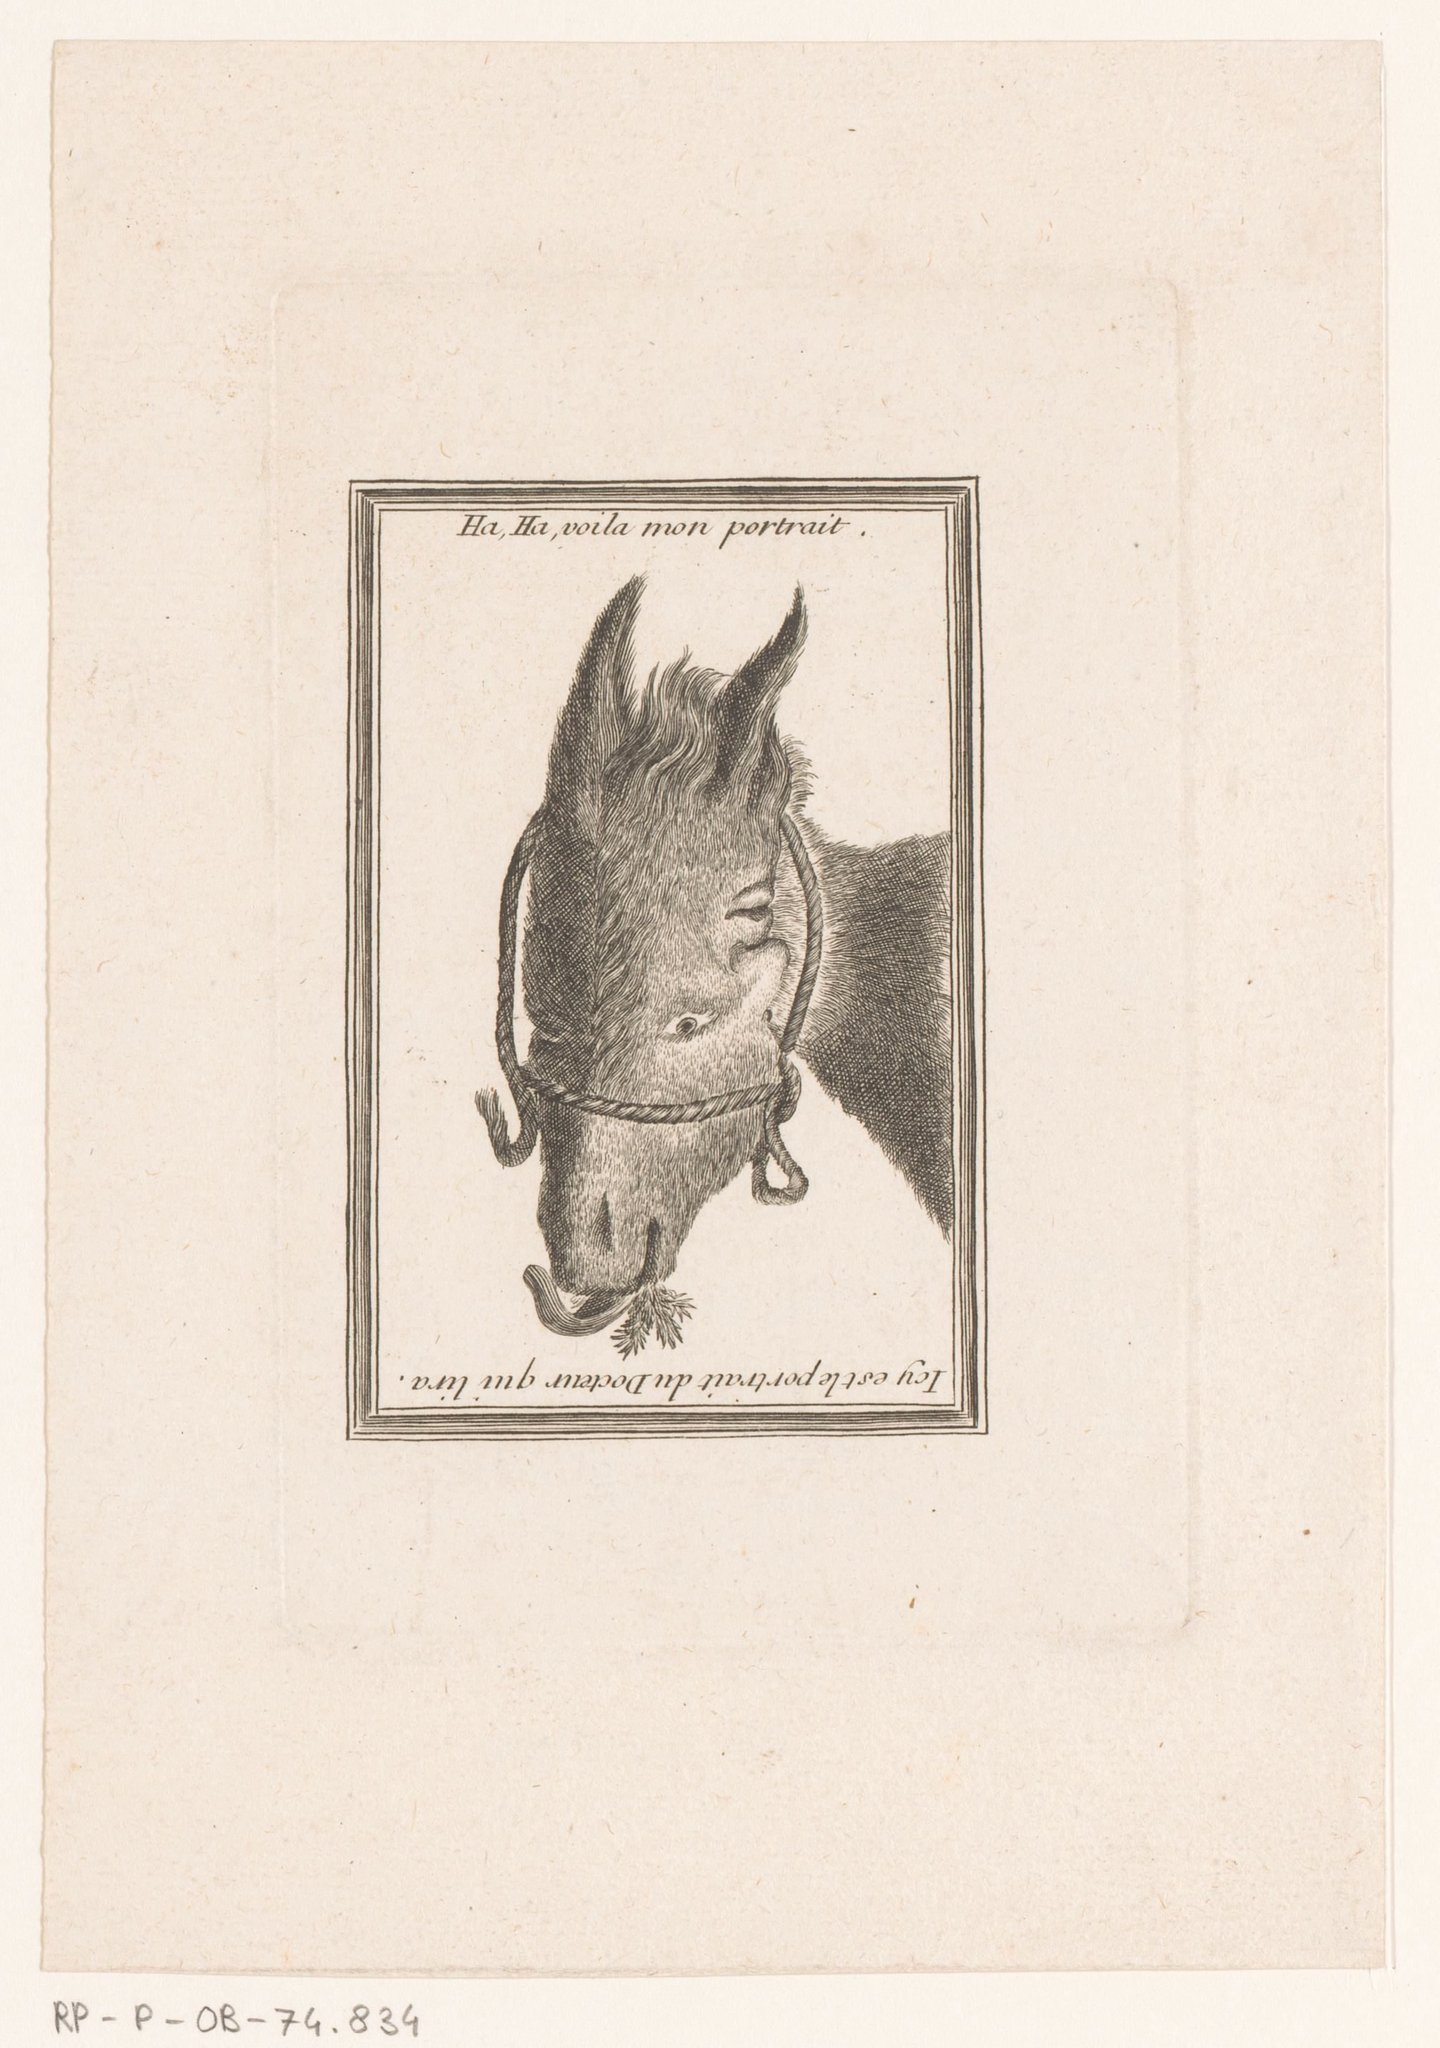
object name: print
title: Kop van ezel en man of duivel ineen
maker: Anonymous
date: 1650-1750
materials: paper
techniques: etching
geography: france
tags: ass, donkey, devil(s) and demons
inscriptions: collector's mark: Lugt 240